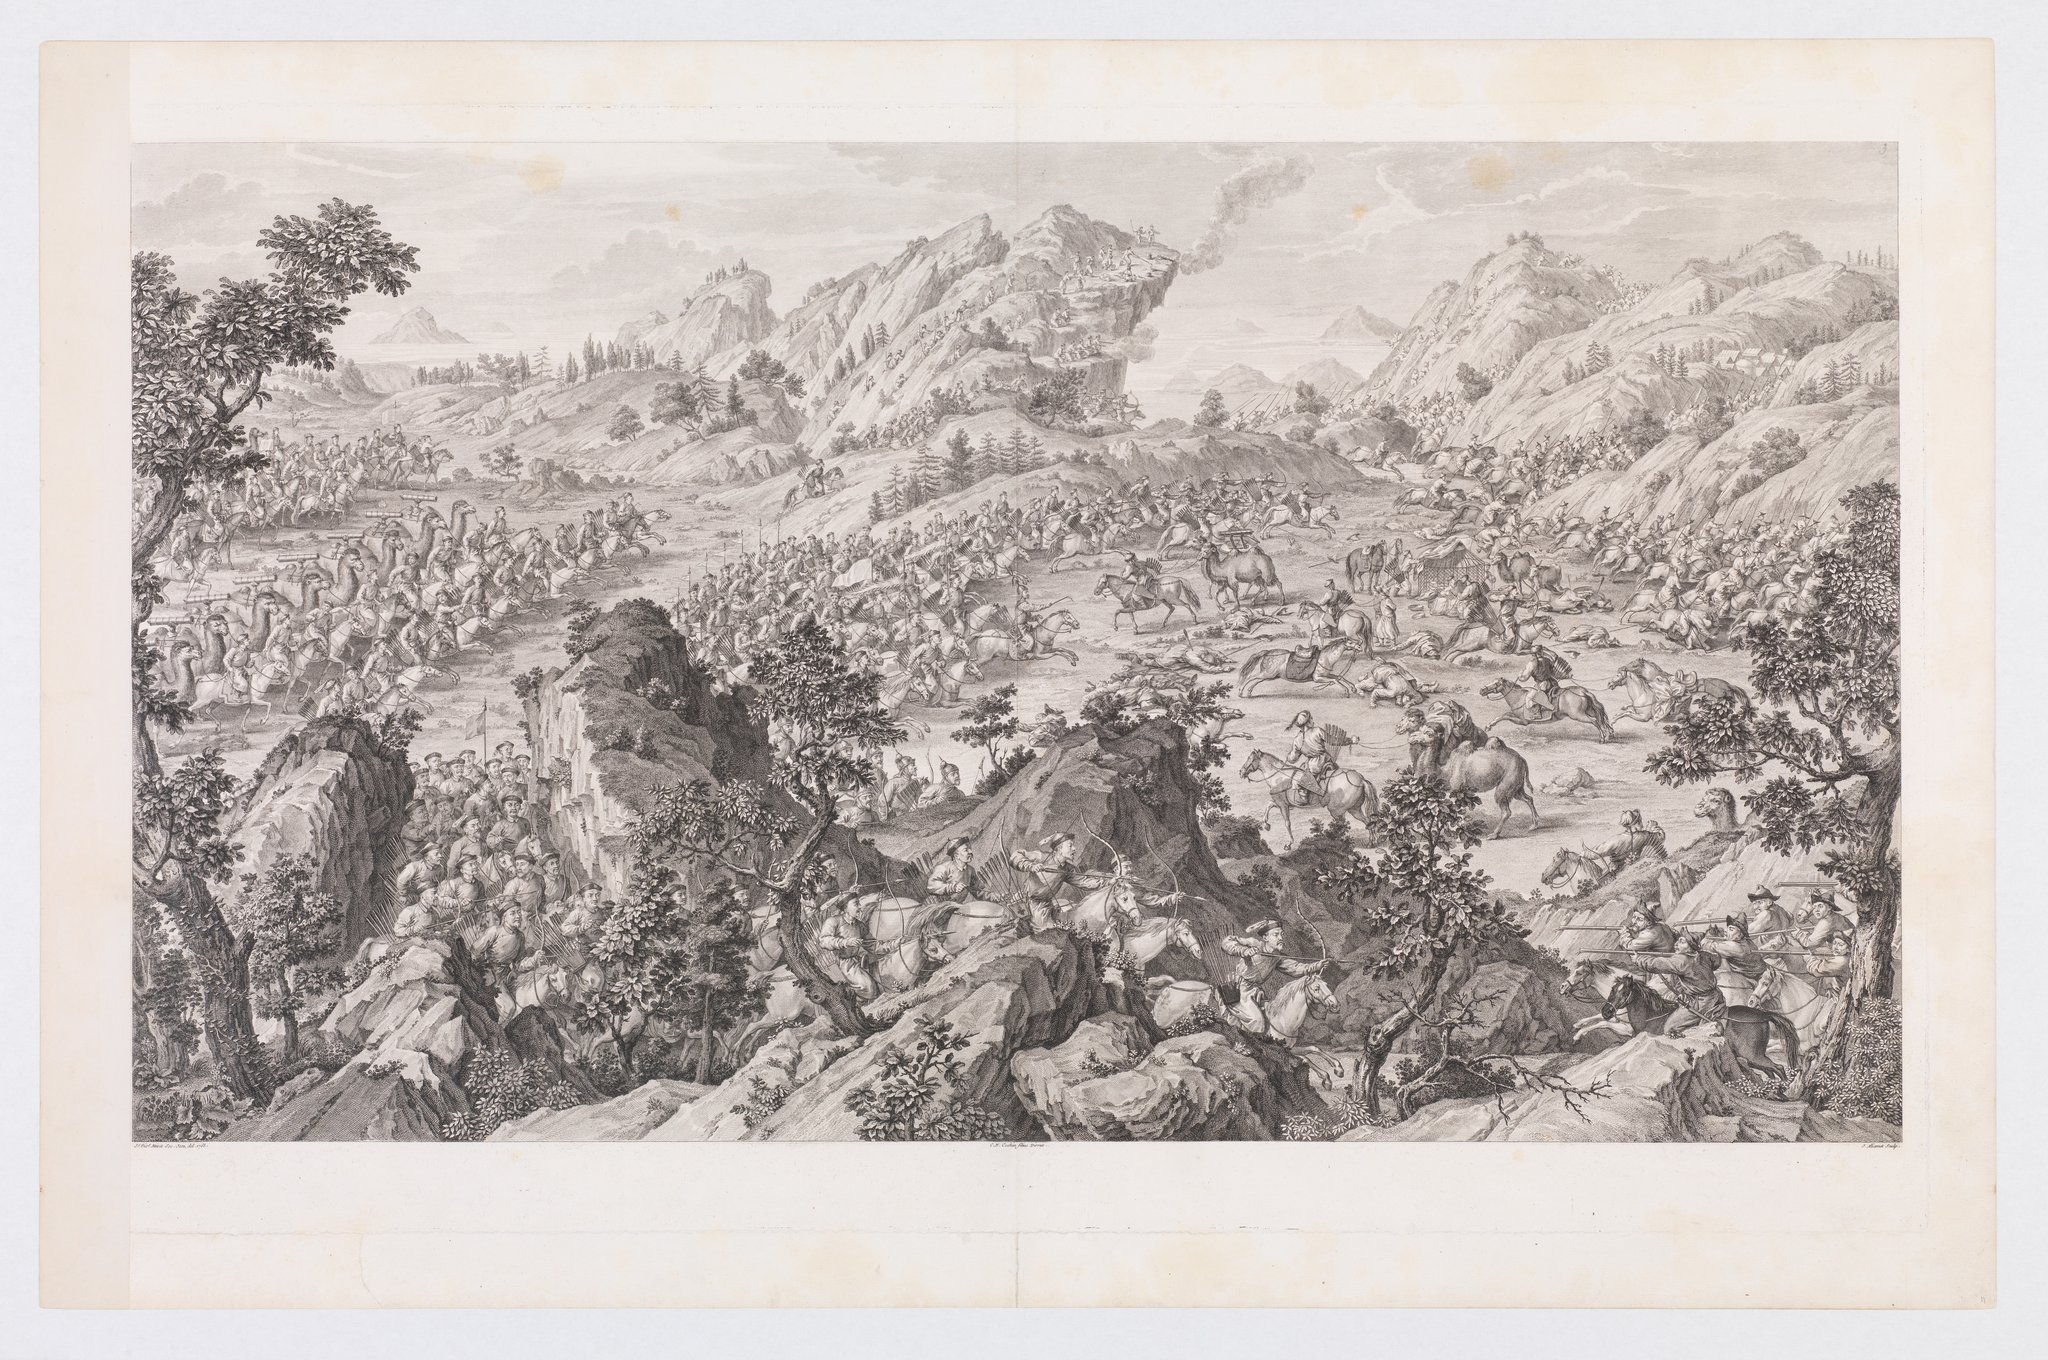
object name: print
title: The Battle of Arcul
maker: benoit louis prevost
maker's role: artist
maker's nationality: french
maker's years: 1747-1804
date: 1767-1774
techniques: engraving, etching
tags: battles,soldiers,horses